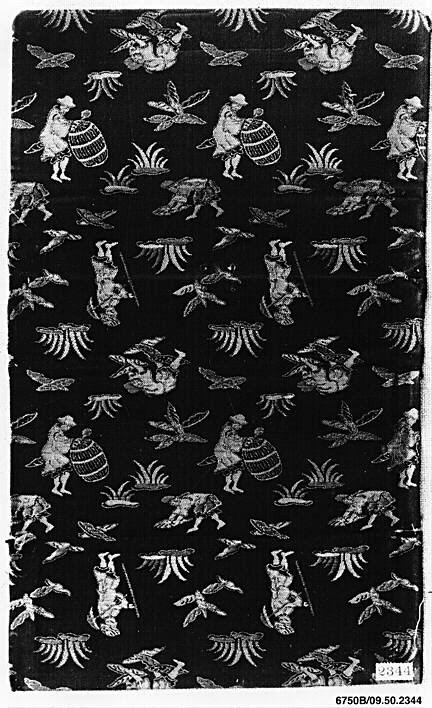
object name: piece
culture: japanese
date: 1801-1900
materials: silk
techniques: damask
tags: human figures,birds